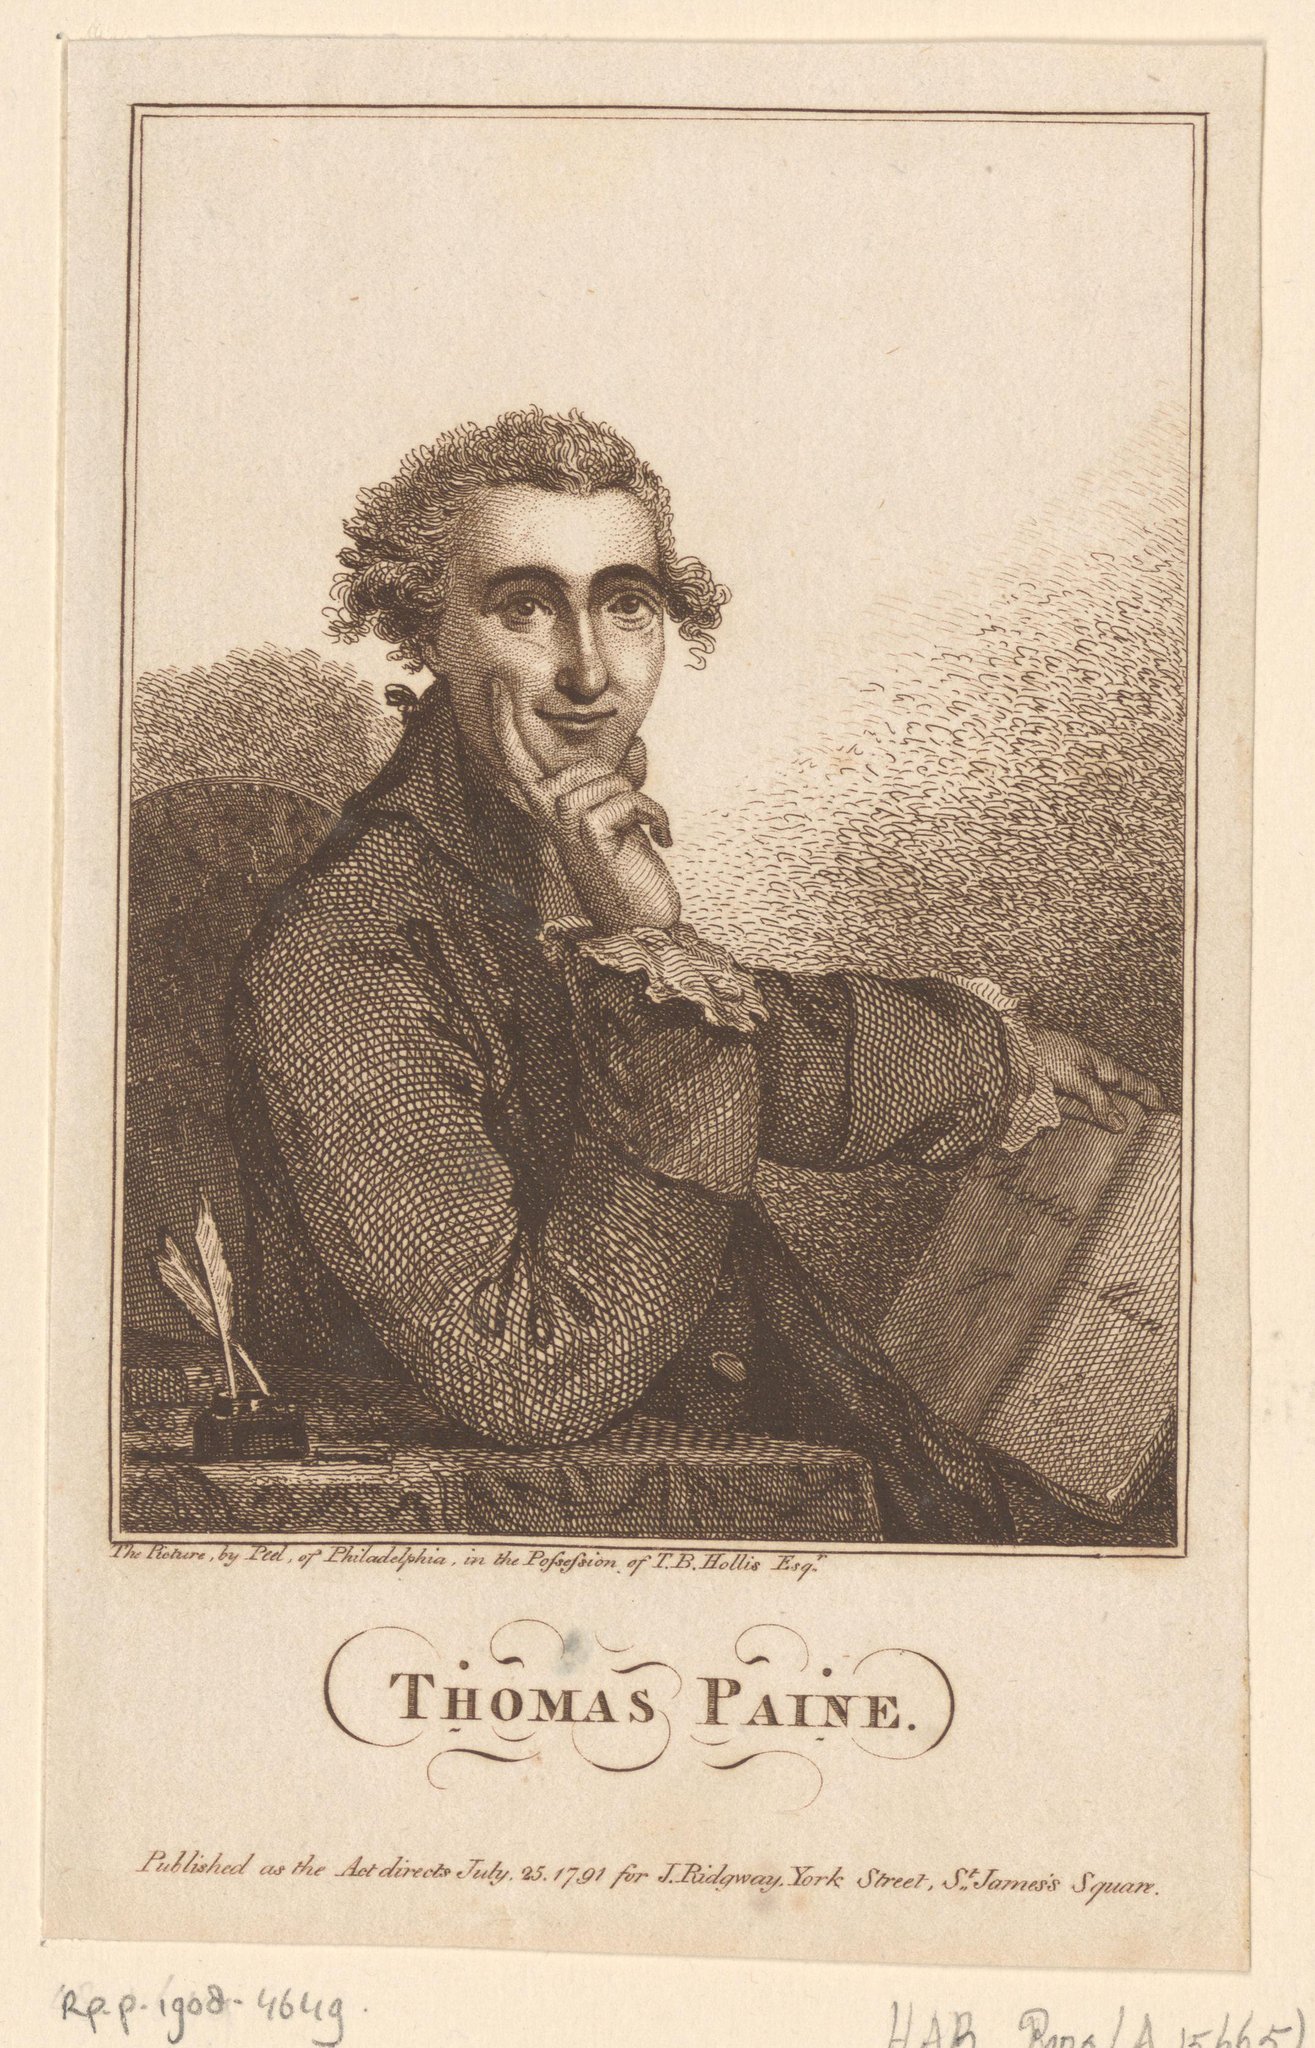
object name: book illustration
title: Portret van Thomas Paine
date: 1792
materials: paper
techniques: etching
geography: london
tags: new york (city), adult man, historical persons, book - mm - book open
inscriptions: collector's mark: Lugt 2228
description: Prent uit: Paine, Thomas. Common Sense : Addressed to the Inhabitants of America. Londen: T. Parsons, 1792.